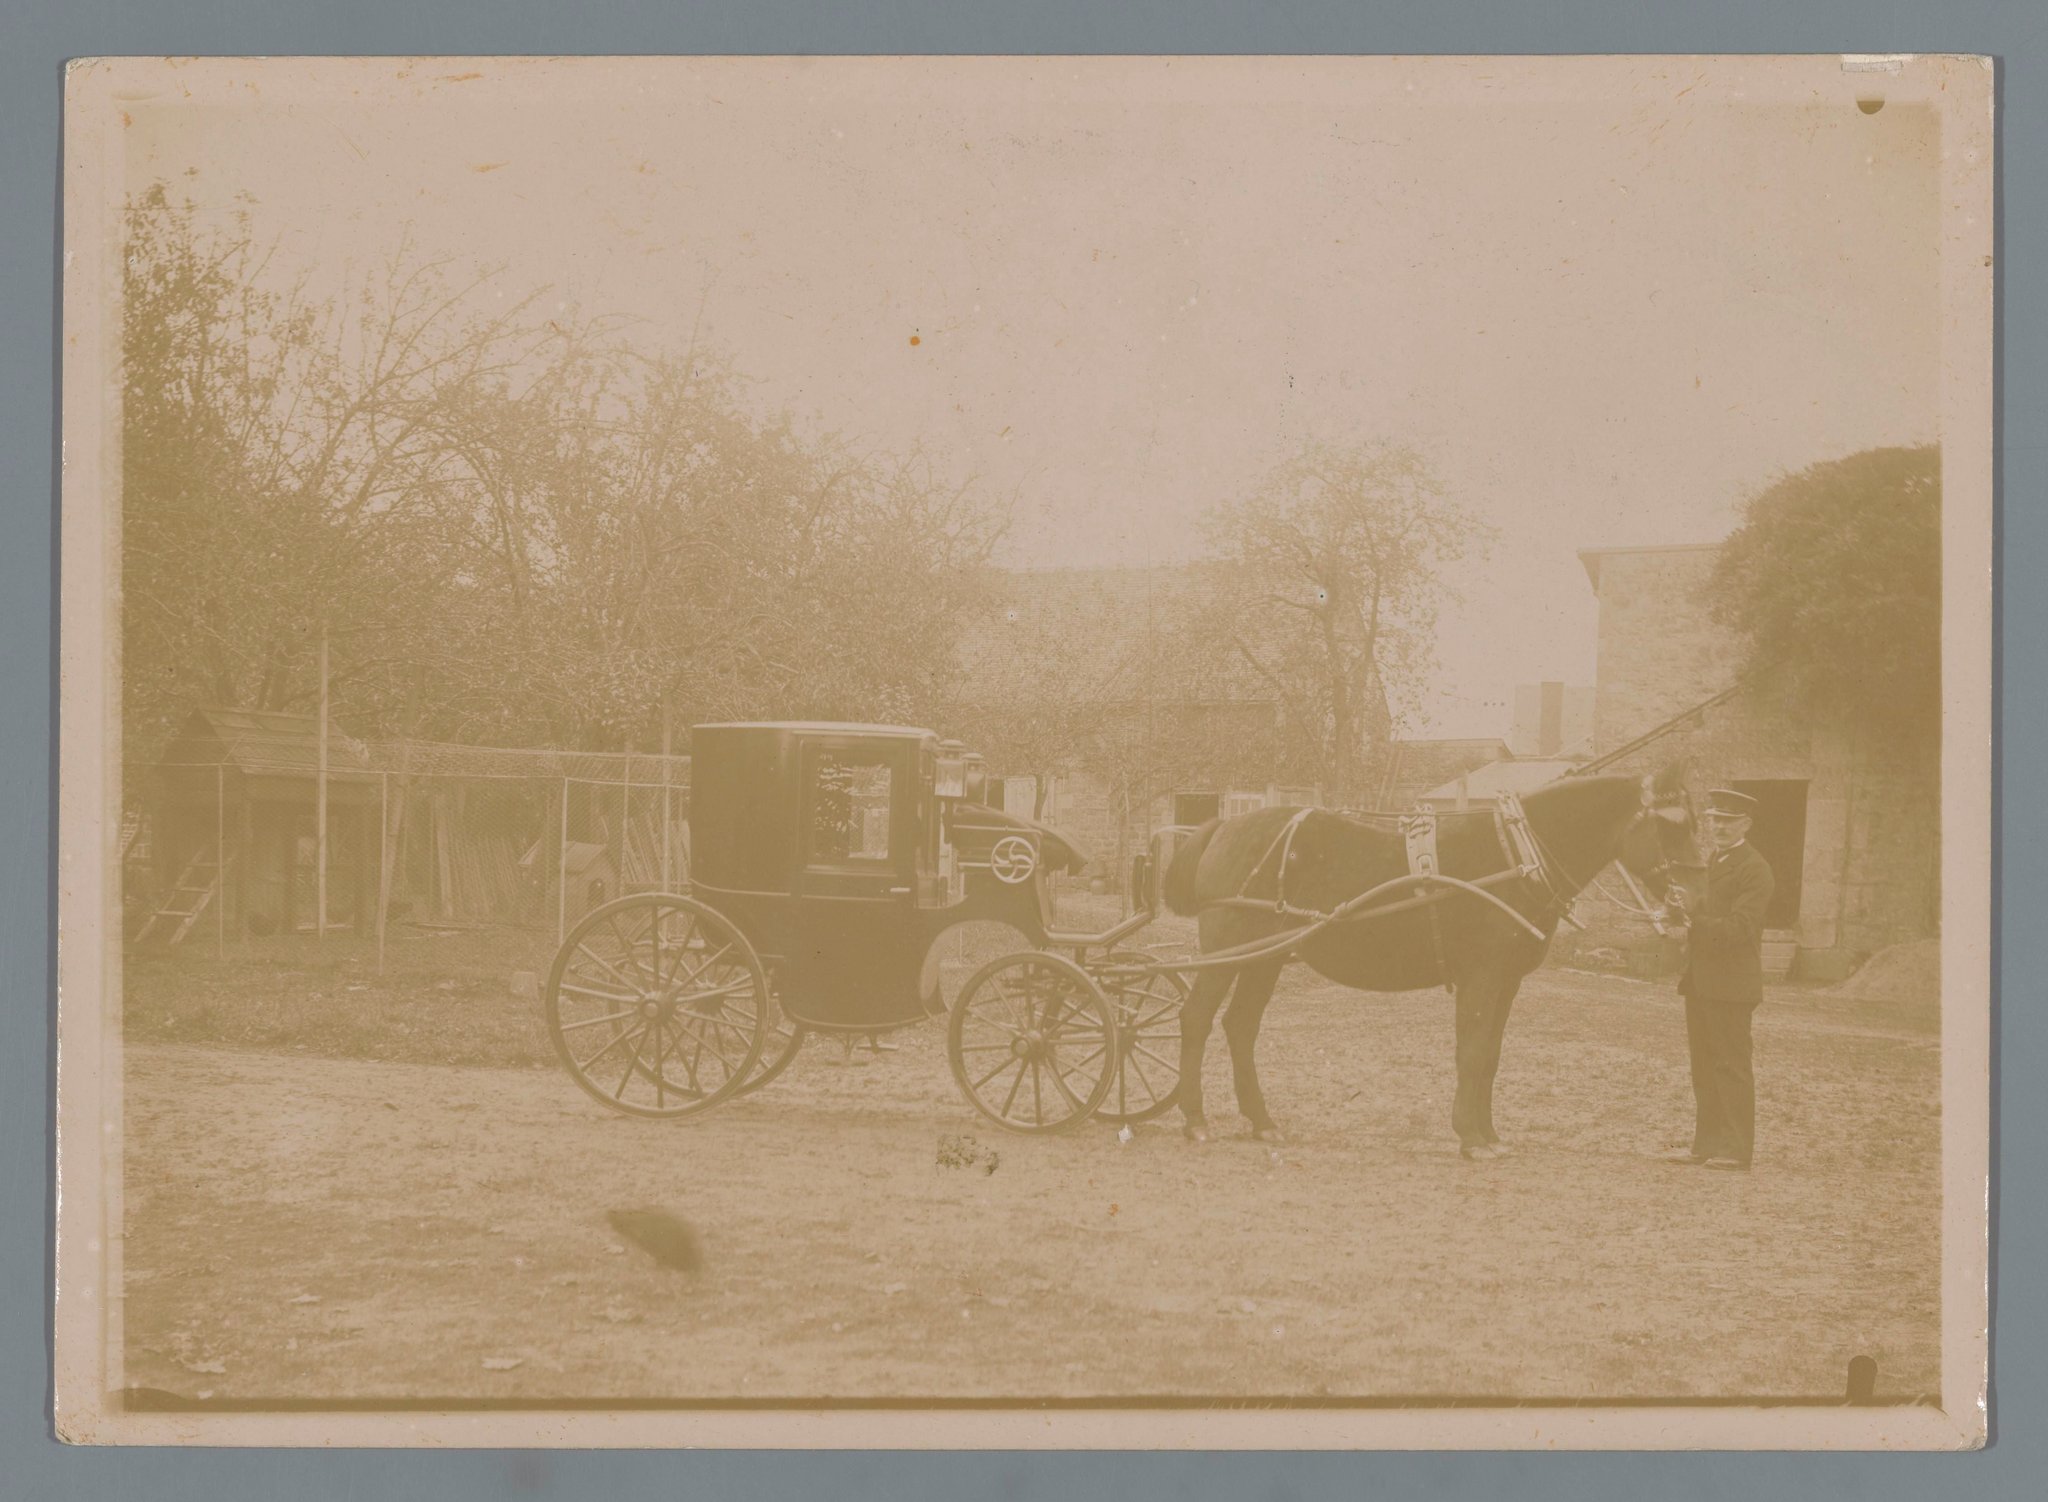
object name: photograph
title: Paardenkoets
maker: Anonymous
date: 1900-1915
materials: cardboard, photographic support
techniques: gelatin silver print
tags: four-wheeled, animal-drawn vehicle, e.g.: cab, carriage, coach